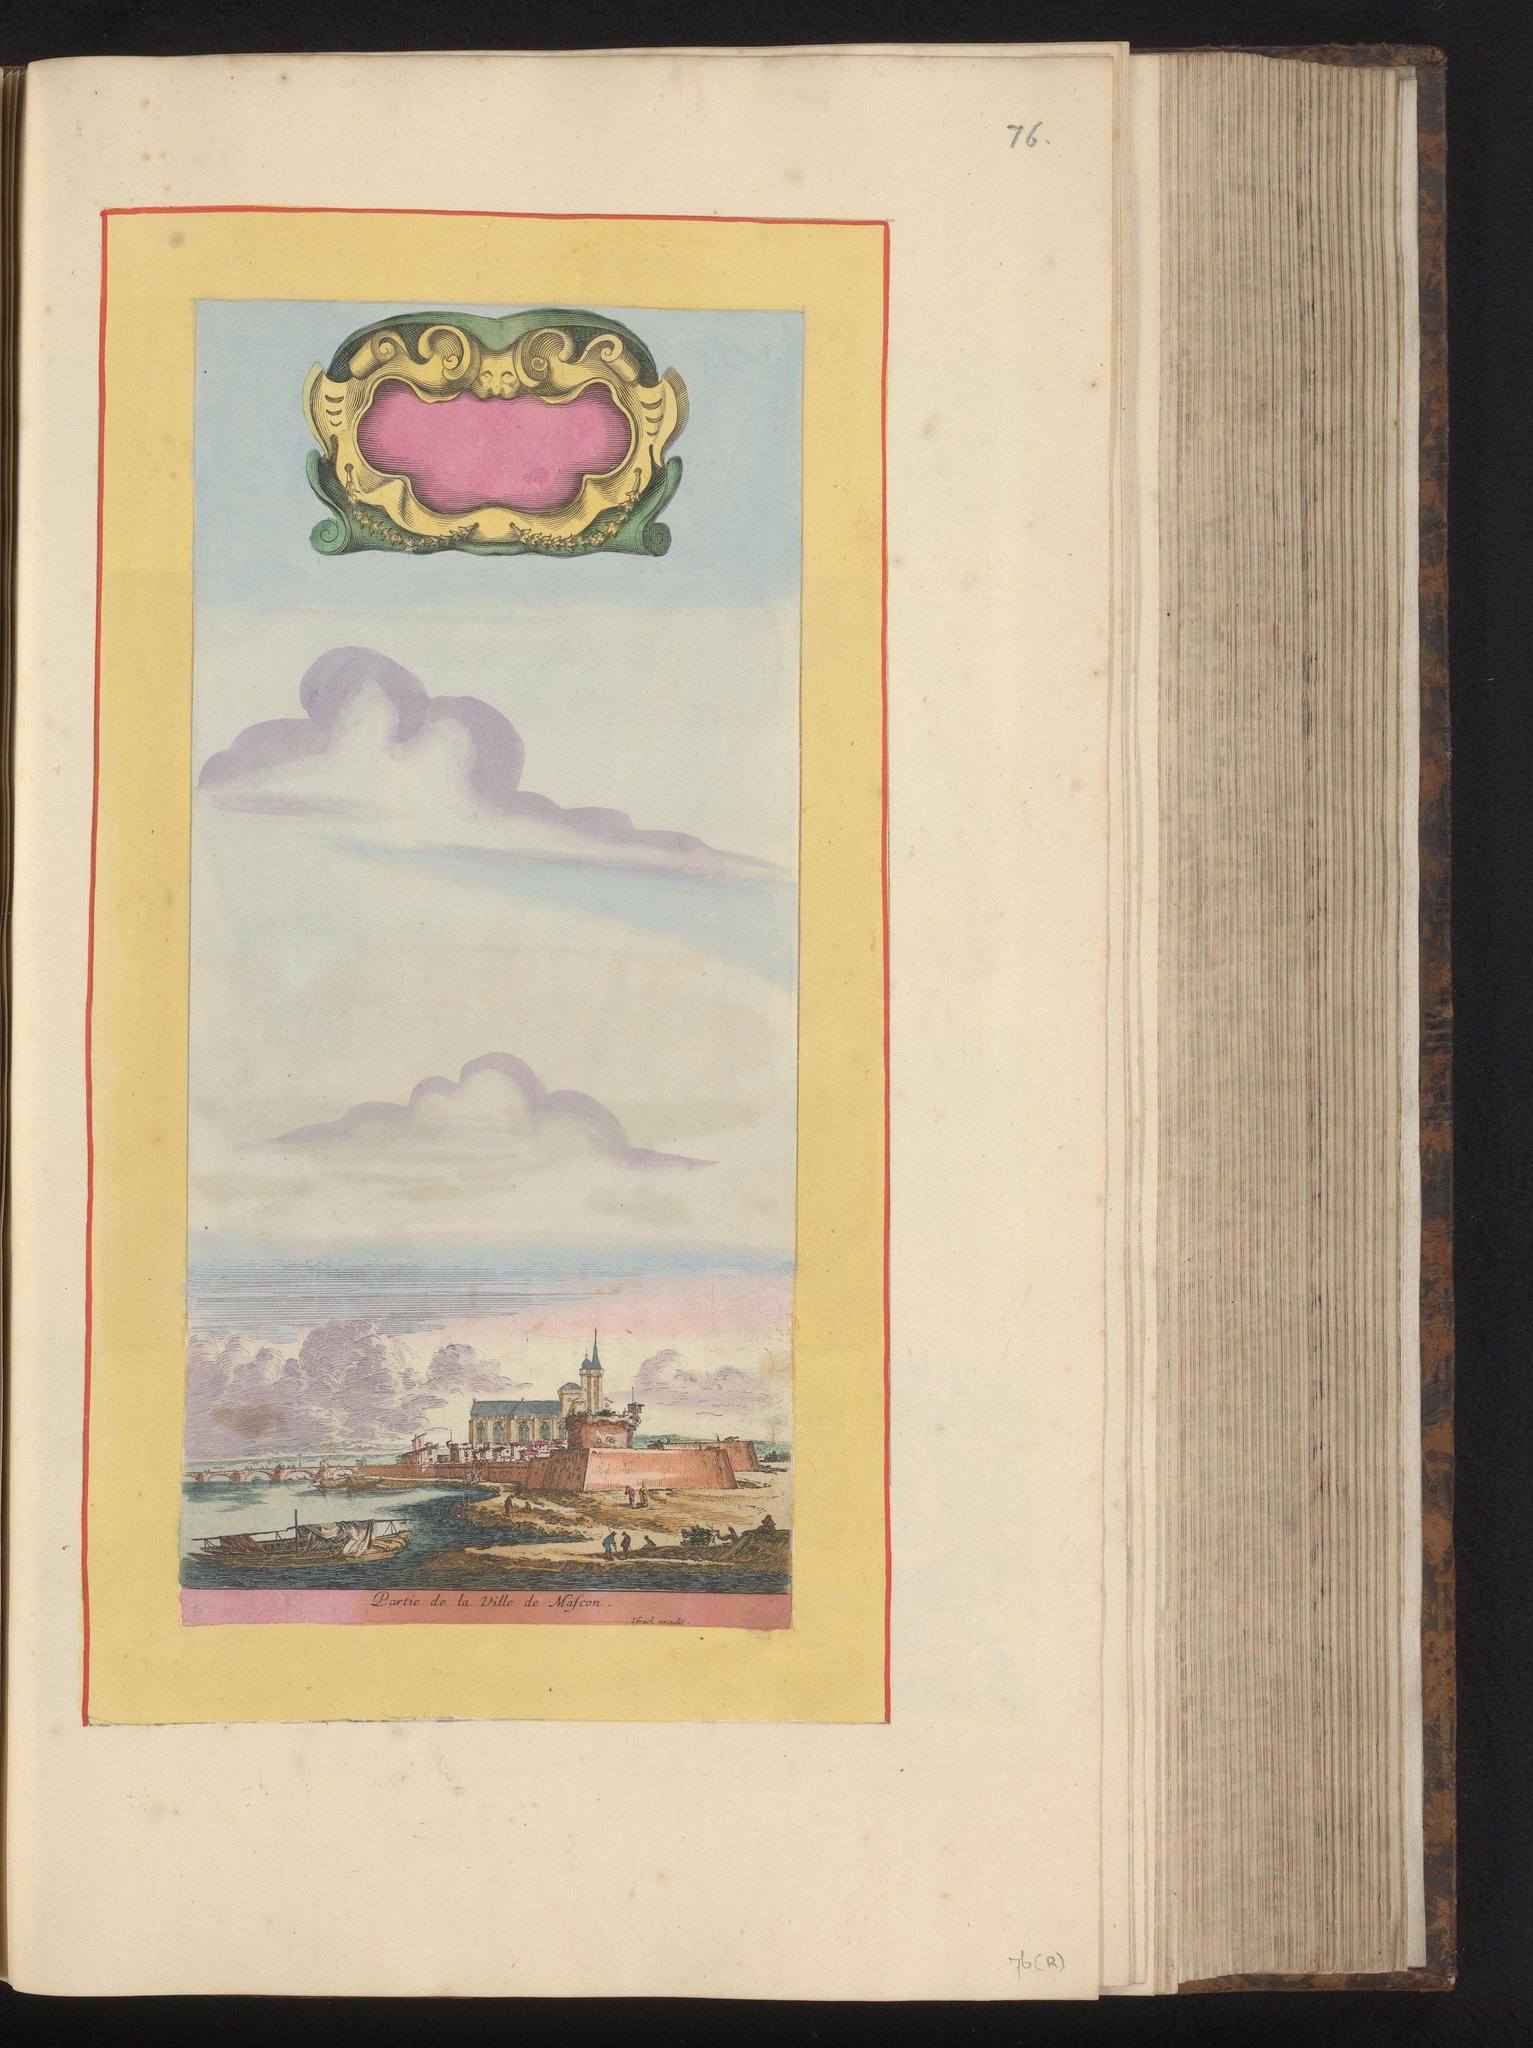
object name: album leaf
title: Partie de la ville de Mascon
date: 1631-1691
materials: paper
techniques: etching, hand coloring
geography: paris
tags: city-view in general; 'veduta'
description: Deze prent maakt deel uit van een album.